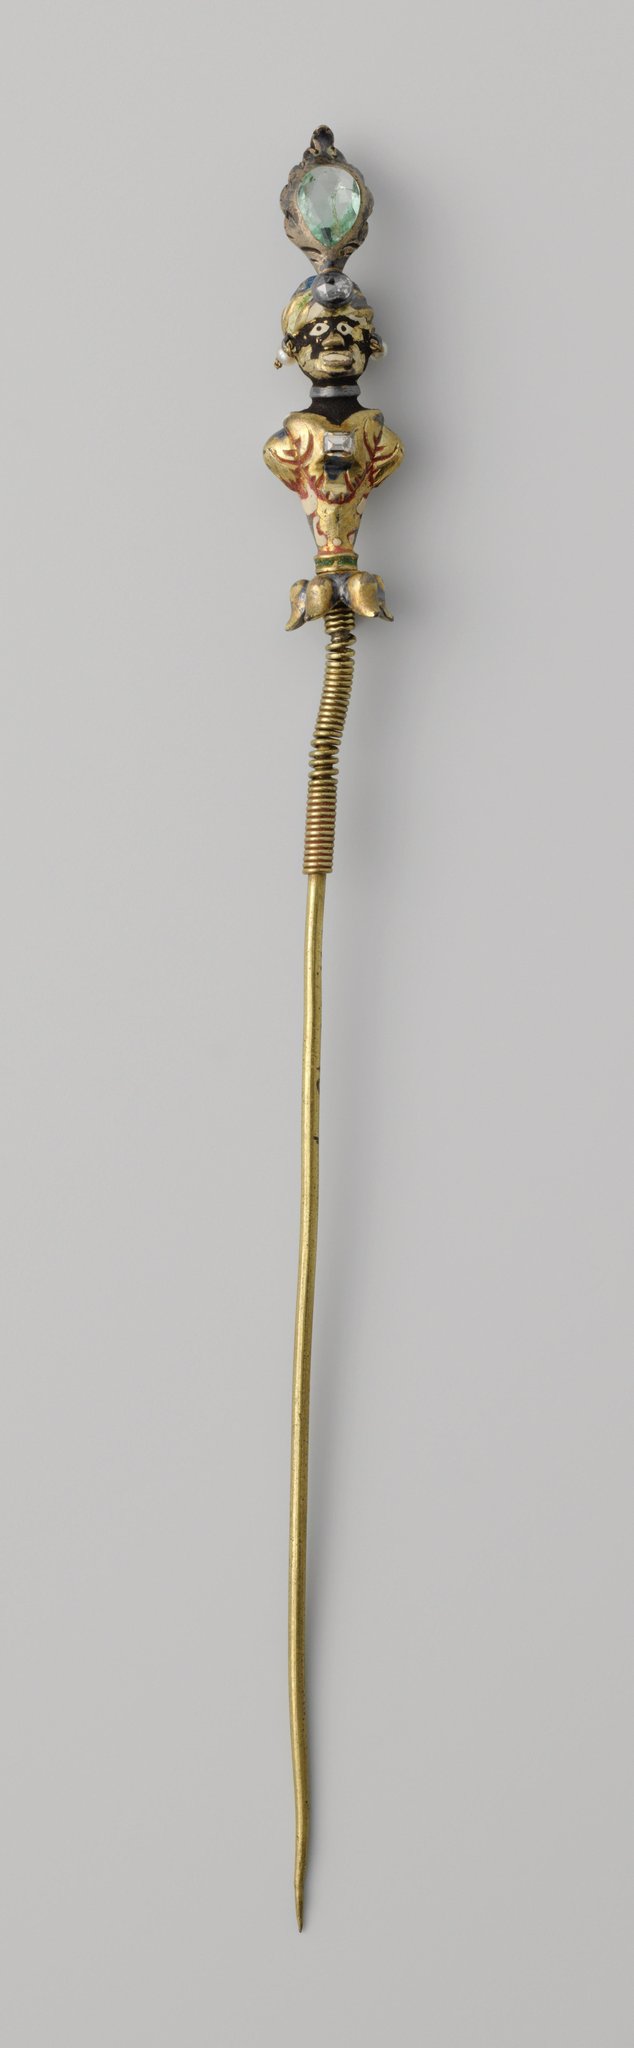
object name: jewellery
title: Haarnaald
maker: Anonymous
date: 1650-1800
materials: enamel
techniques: enamel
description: Haarnaald met bovenop een geëmailleerde morekop. Versierd met steentjes.